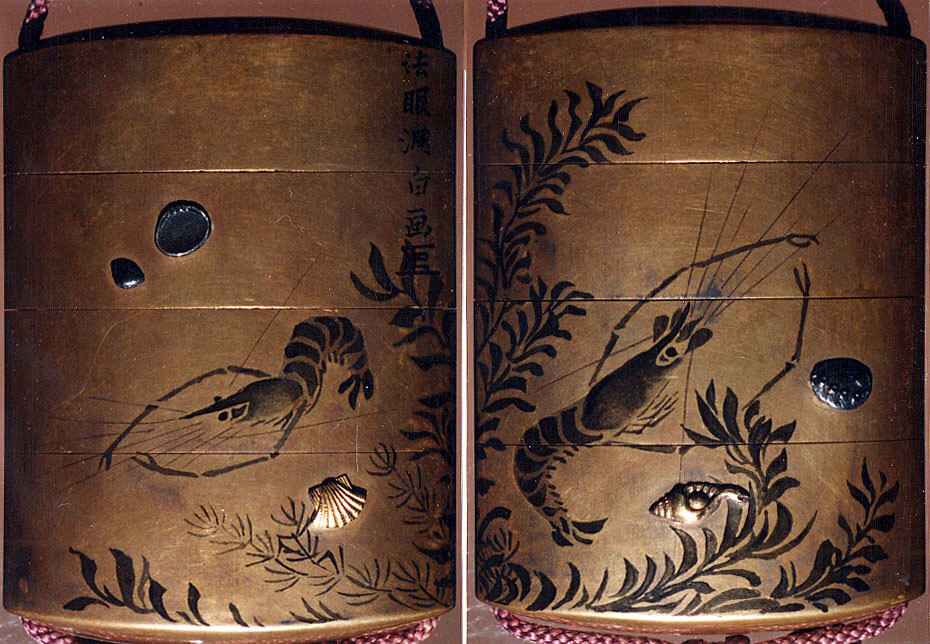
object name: inrō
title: Case (Inrō) with Design of Crawfish and Scattered Shells beside Water Weeds and Plants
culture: japanese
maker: hogen dohaku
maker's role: artist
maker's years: 1851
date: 1801-1900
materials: lacquer, metal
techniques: fundame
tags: fish,shells